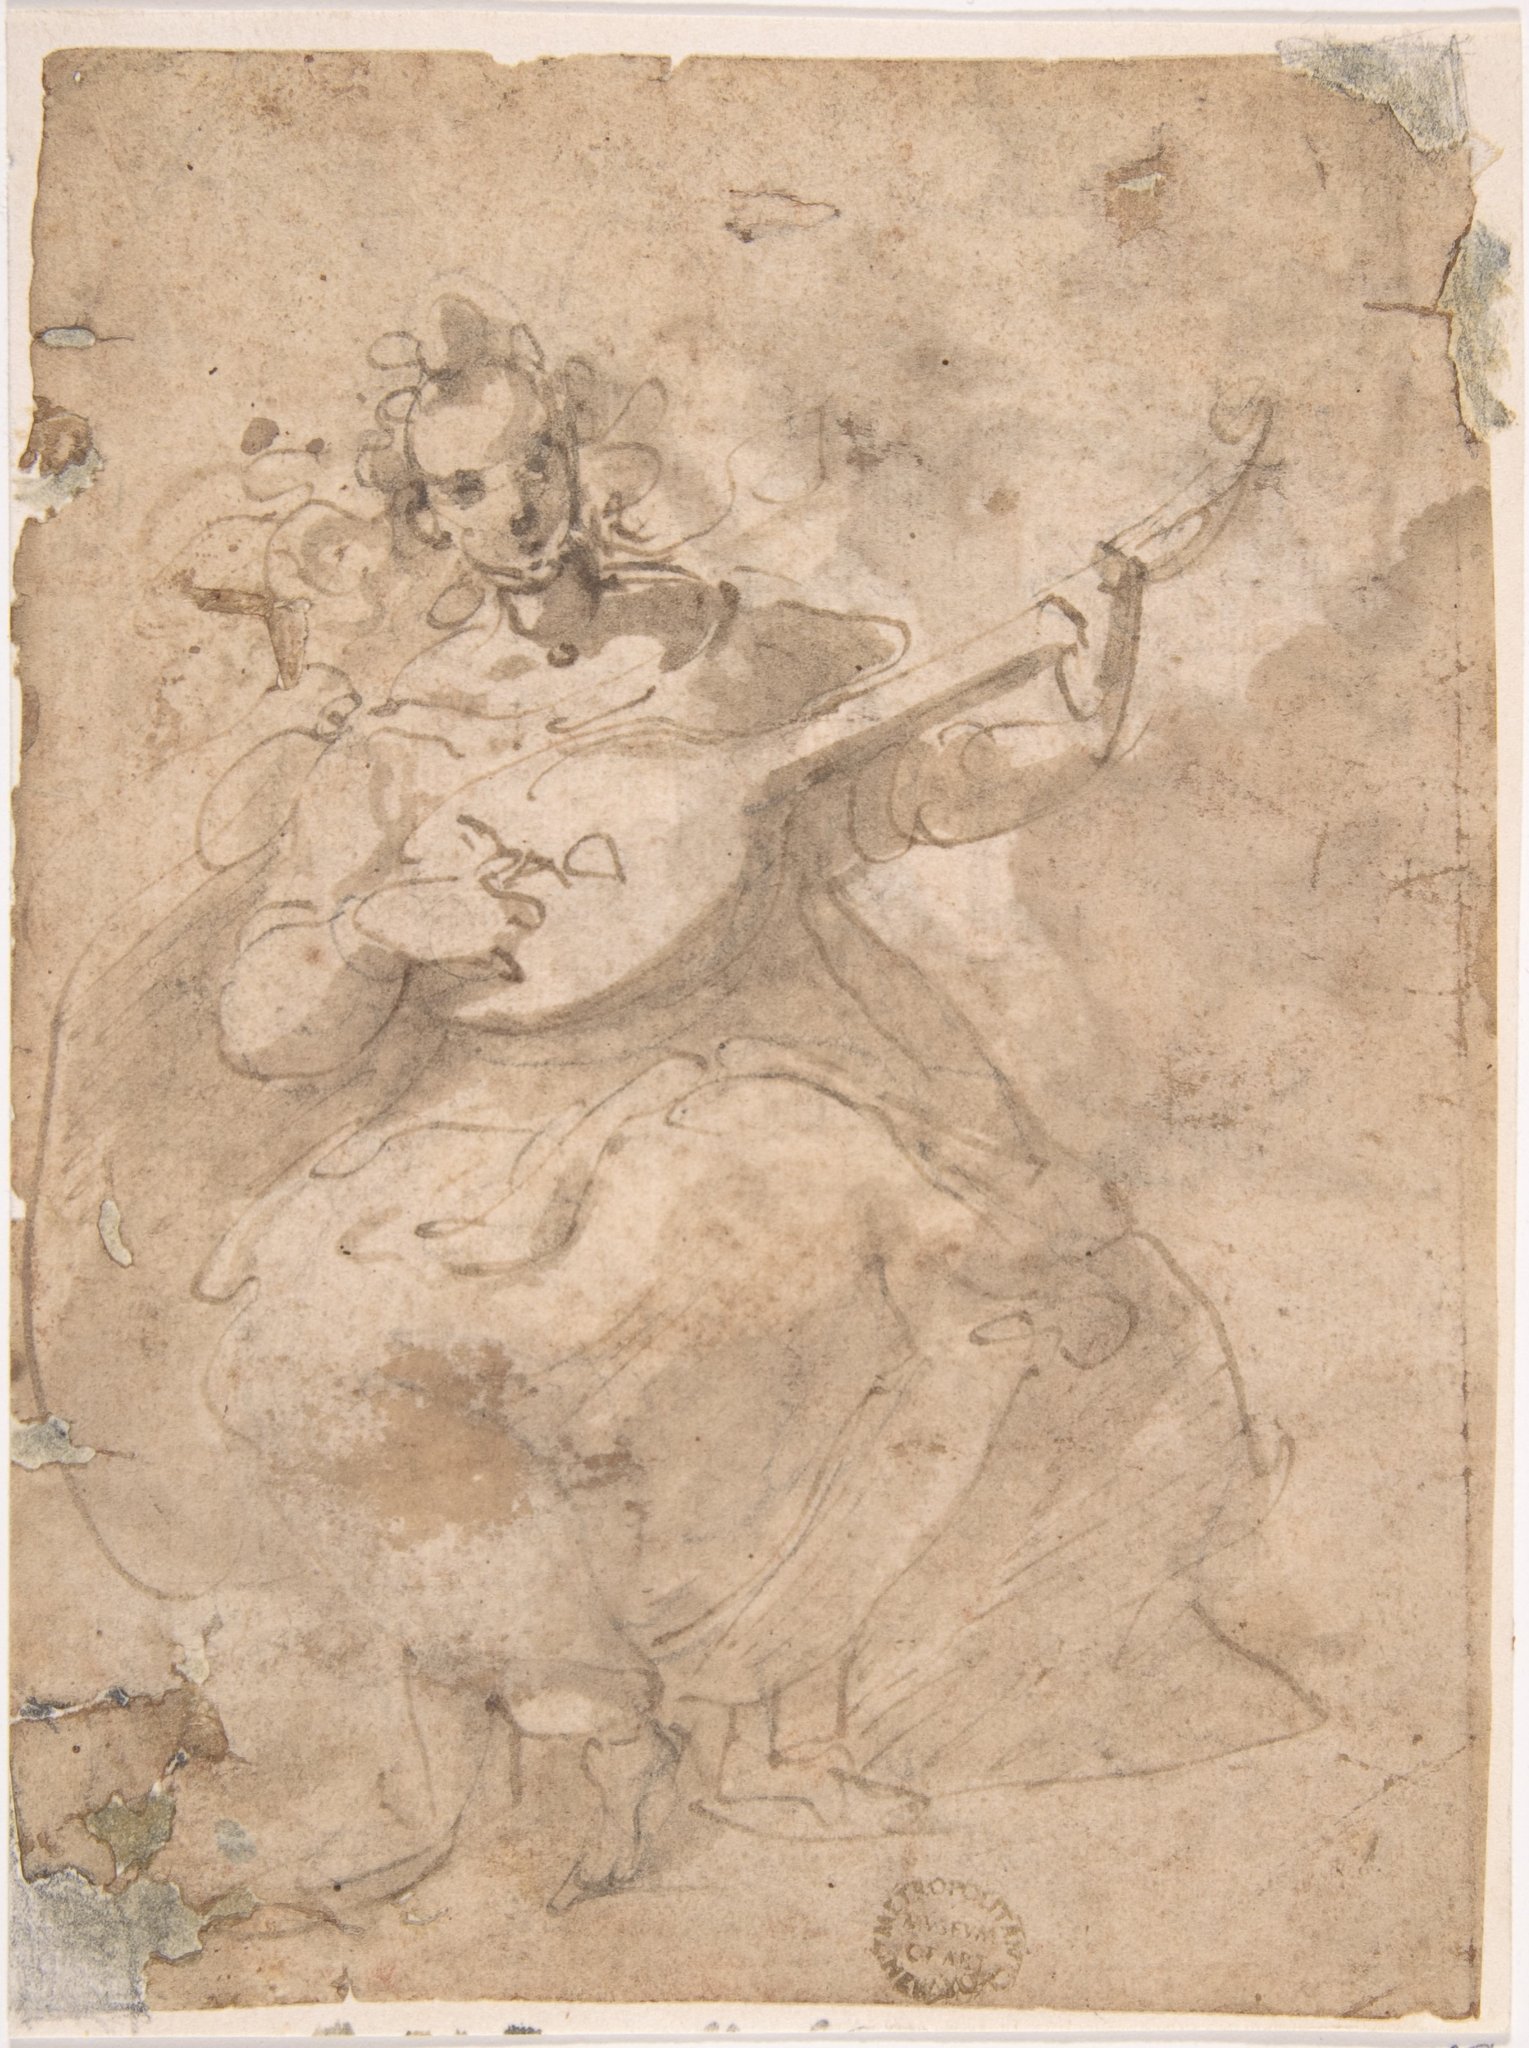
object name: drawing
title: Girl Playing a Lute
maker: anonymous, italian, roman-bolognese, 17th century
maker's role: artist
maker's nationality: italian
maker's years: 1600-1700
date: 1601-1700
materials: chalk, ink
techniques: brush, pen, wash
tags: girls,lutes